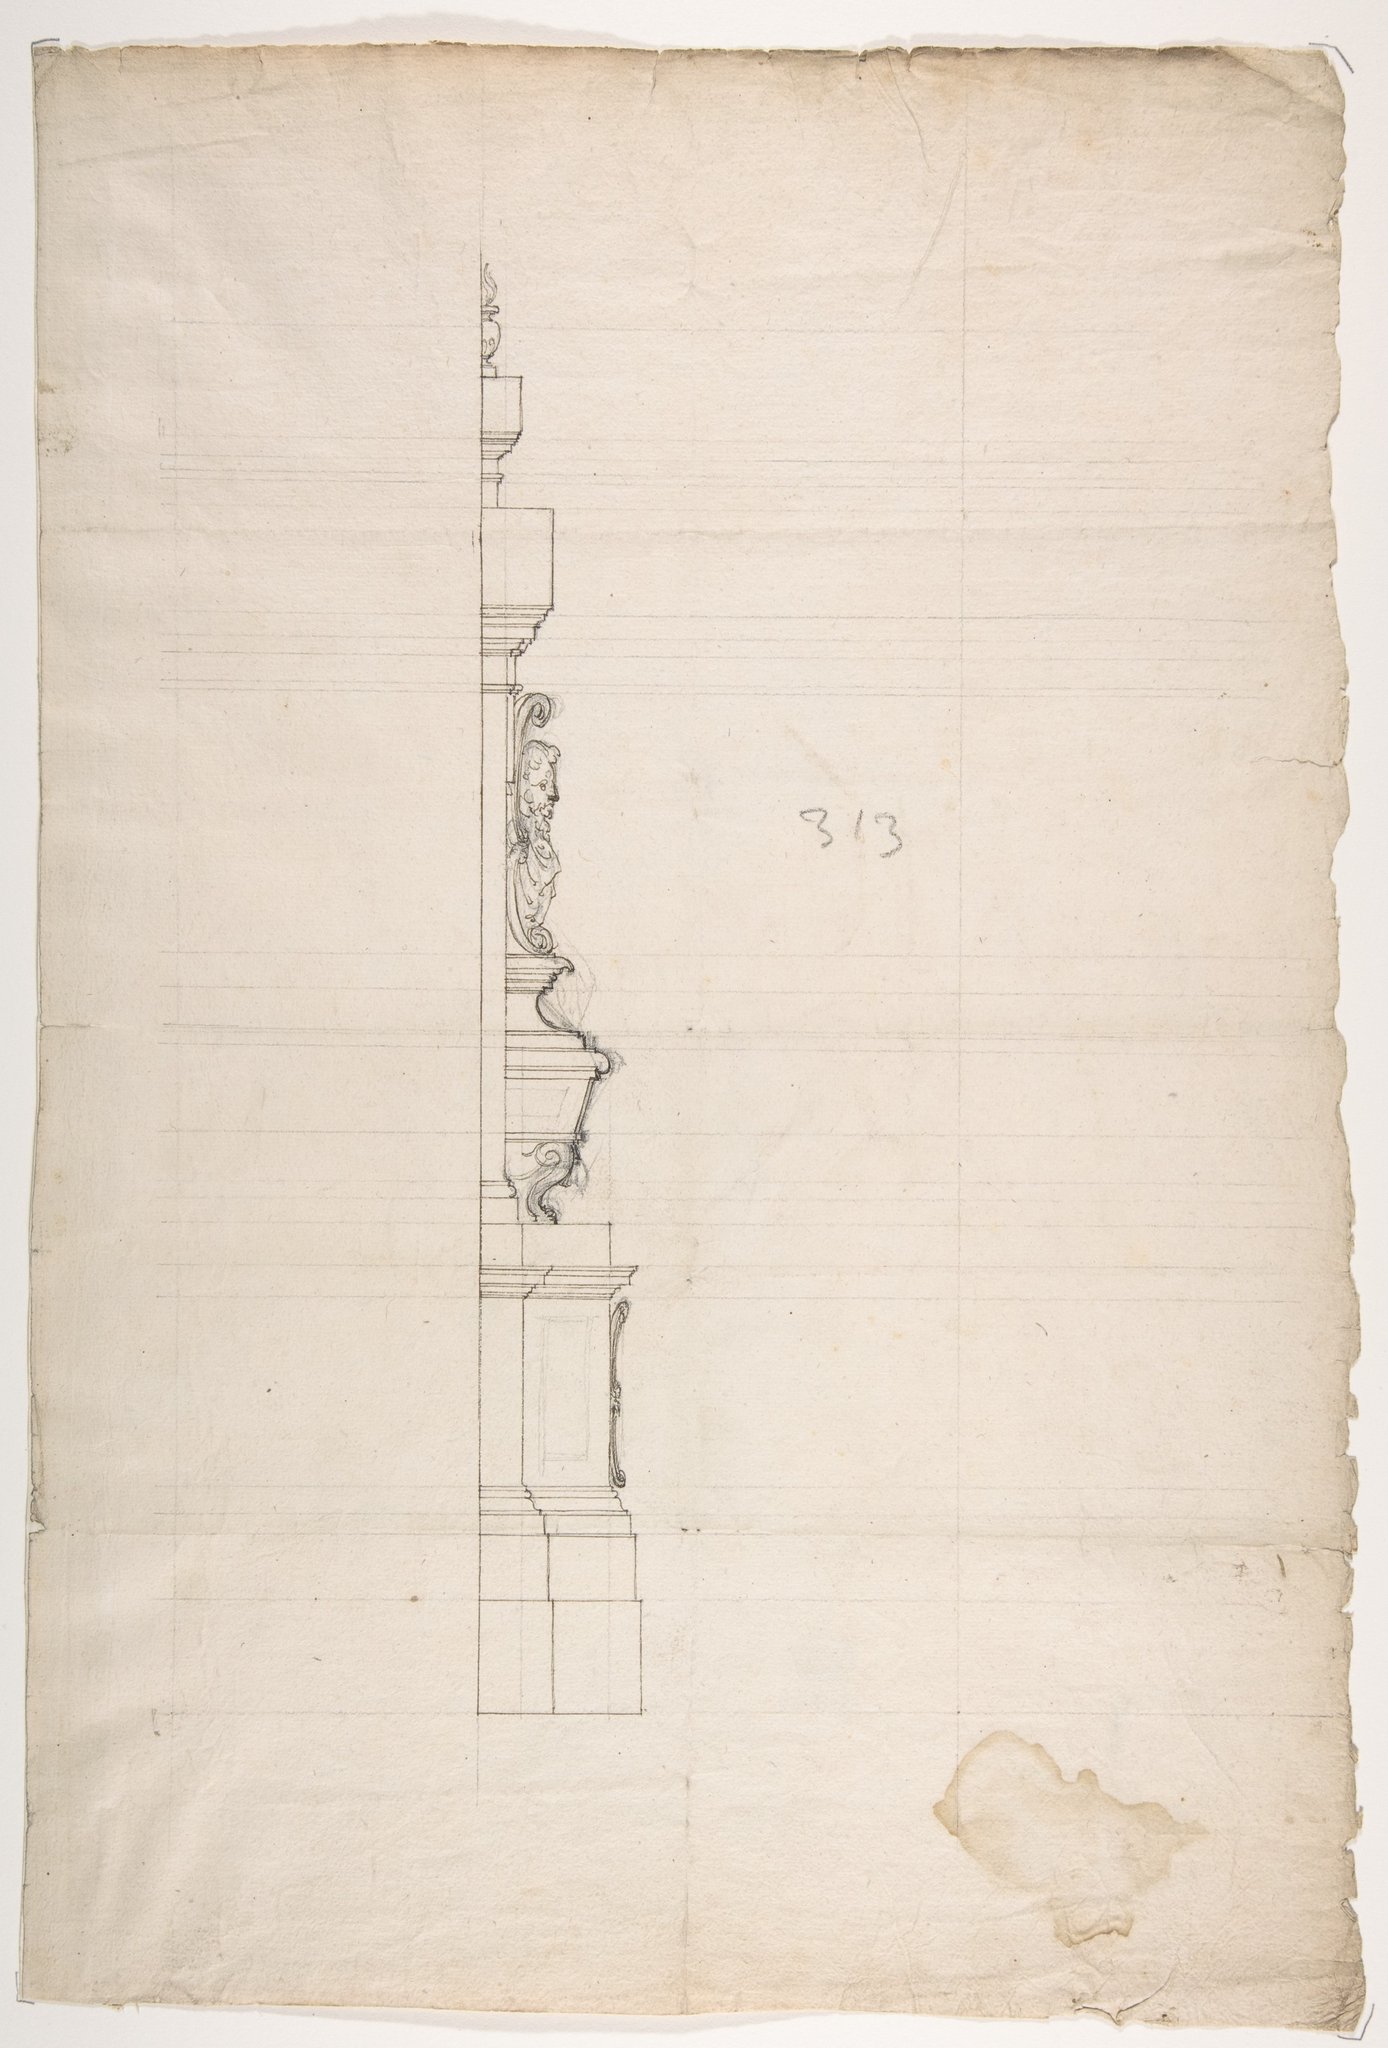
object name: drawing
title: Profile of a Design for a Tomb with a Male Bust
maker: anonymous, french, 16th century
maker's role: artist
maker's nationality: french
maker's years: 1500-1600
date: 1501-1600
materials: graphite, ink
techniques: pen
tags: tombs,men